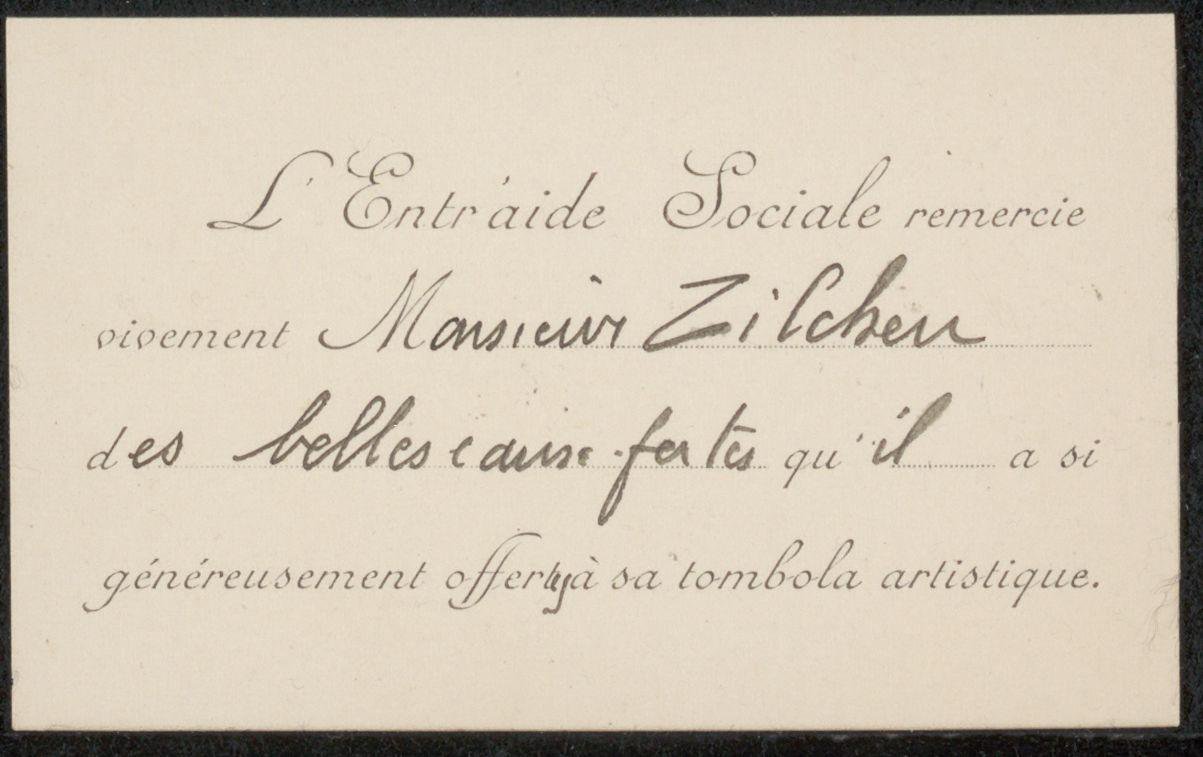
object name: letter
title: Brief aan Philip Zilcken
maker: Anonymous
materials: cardboard, ink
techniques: pen, printing, writing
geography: france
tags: the hague, painter, draughtsman, philip zilcken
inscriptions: collector's mark: ‘RPK’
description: Betreft een bedankkaartje namens de charitatieve organisatie l'Entr'aide Sociale aan Philip Zilcken voor diens bijdrage aan een verloting van kunstwerken.